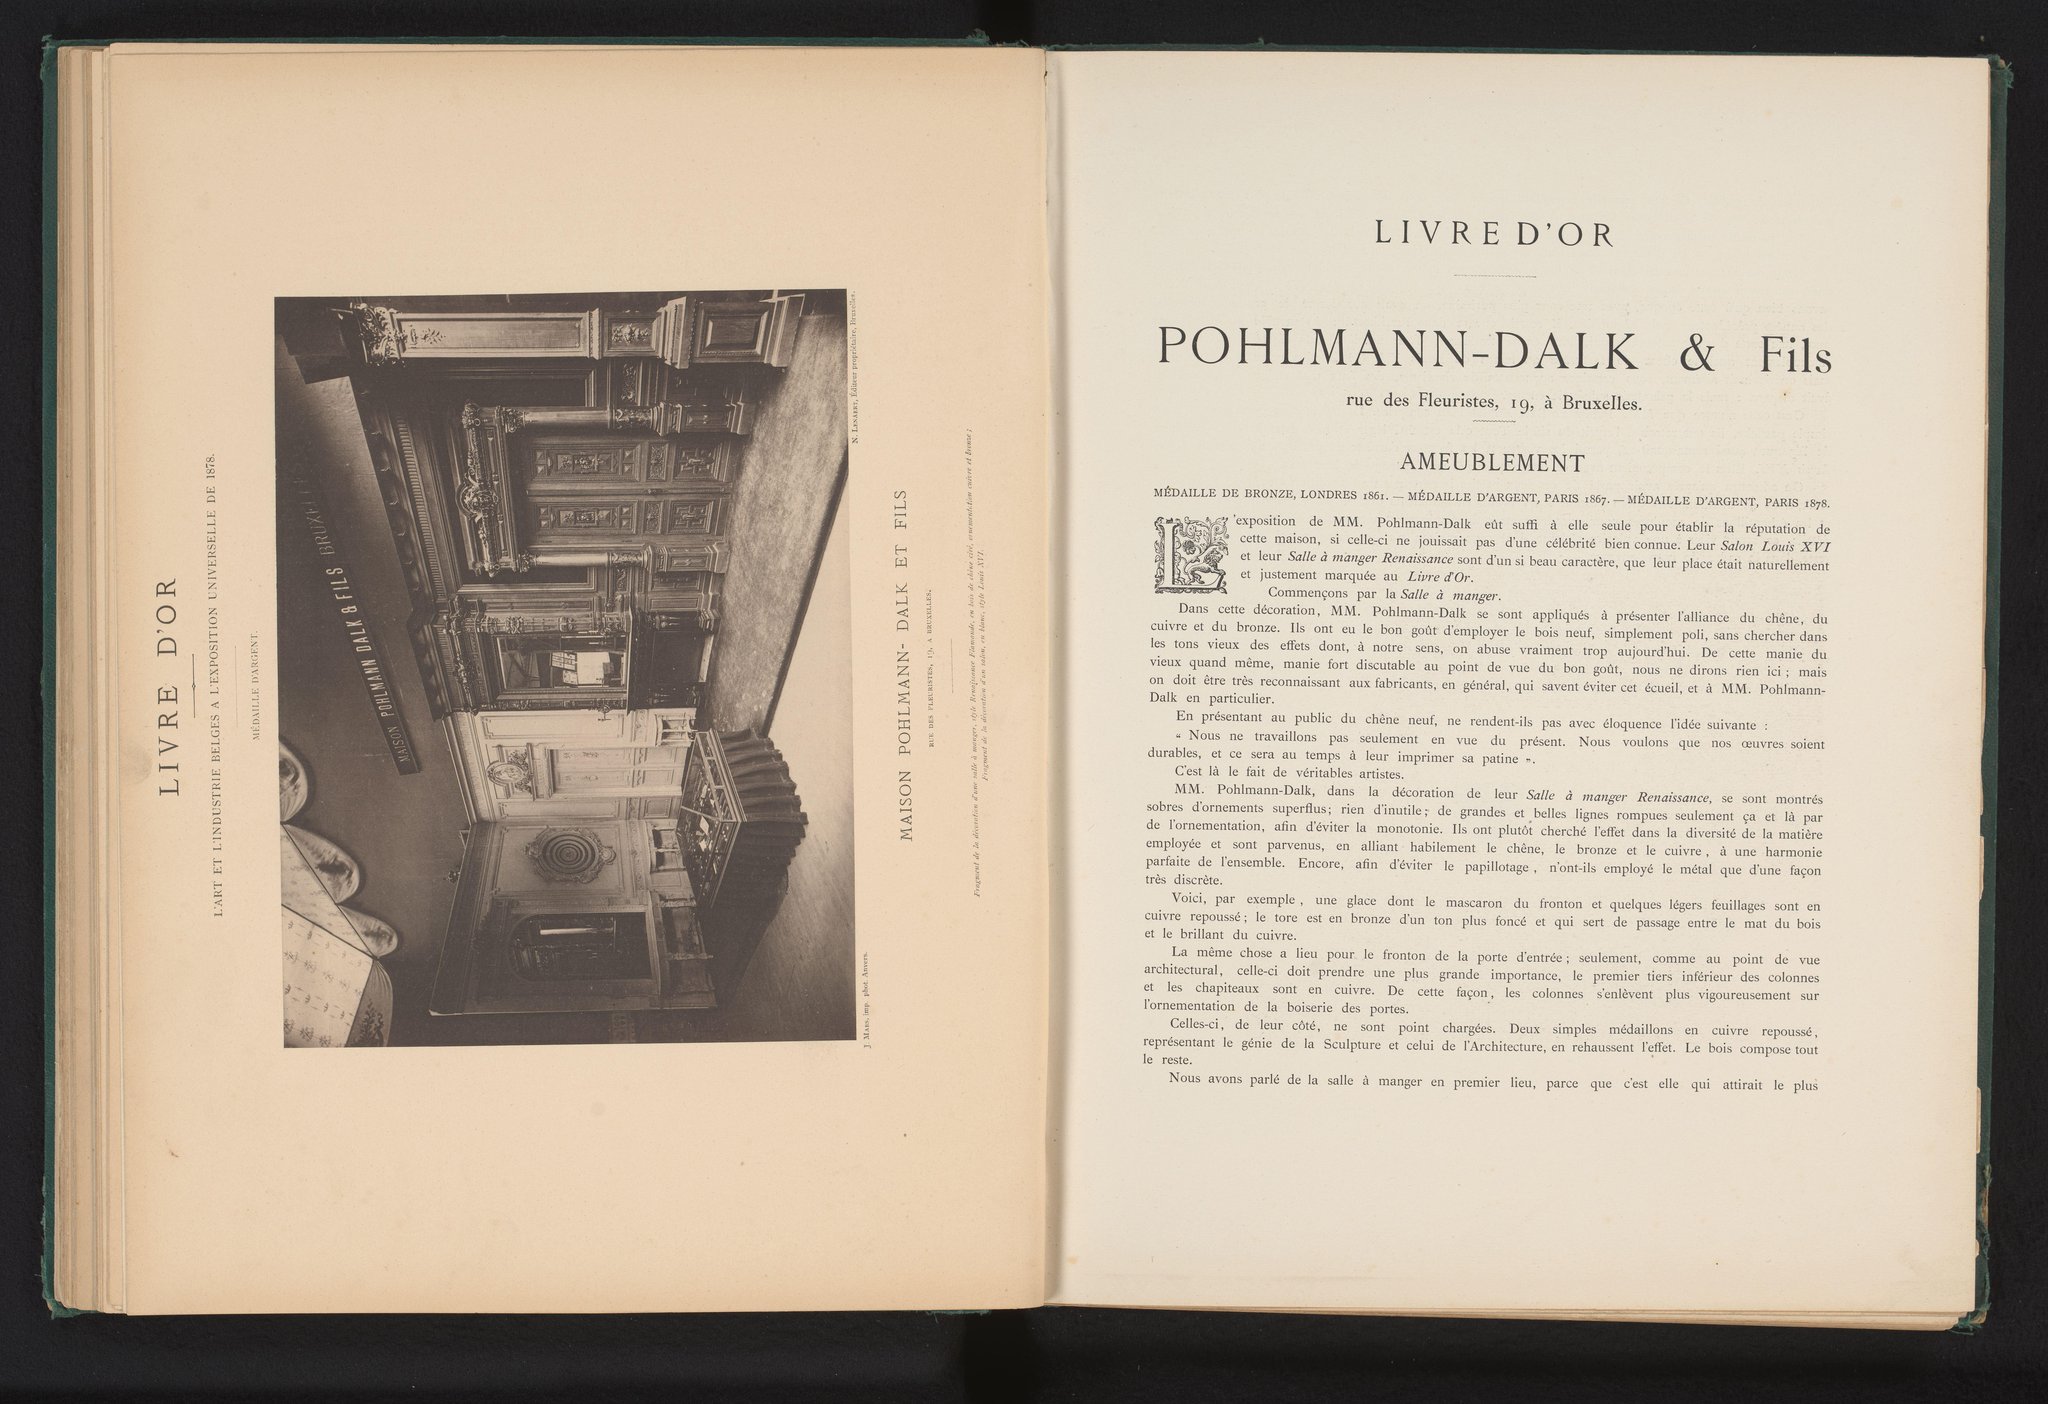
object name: photomechanical print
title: Maison Pohlmann- Dalk et Fils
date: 1874-1879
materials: paper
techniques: photograph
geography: antwerp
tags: world fair, world exhibition, dining-room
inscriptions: inscription: ‘Livre d'or/ L'art et l'industrie Belges a l'exposition universelle de 1878.’, inscription: ‘Fragment de la decoration d'une salle à manger (...)’